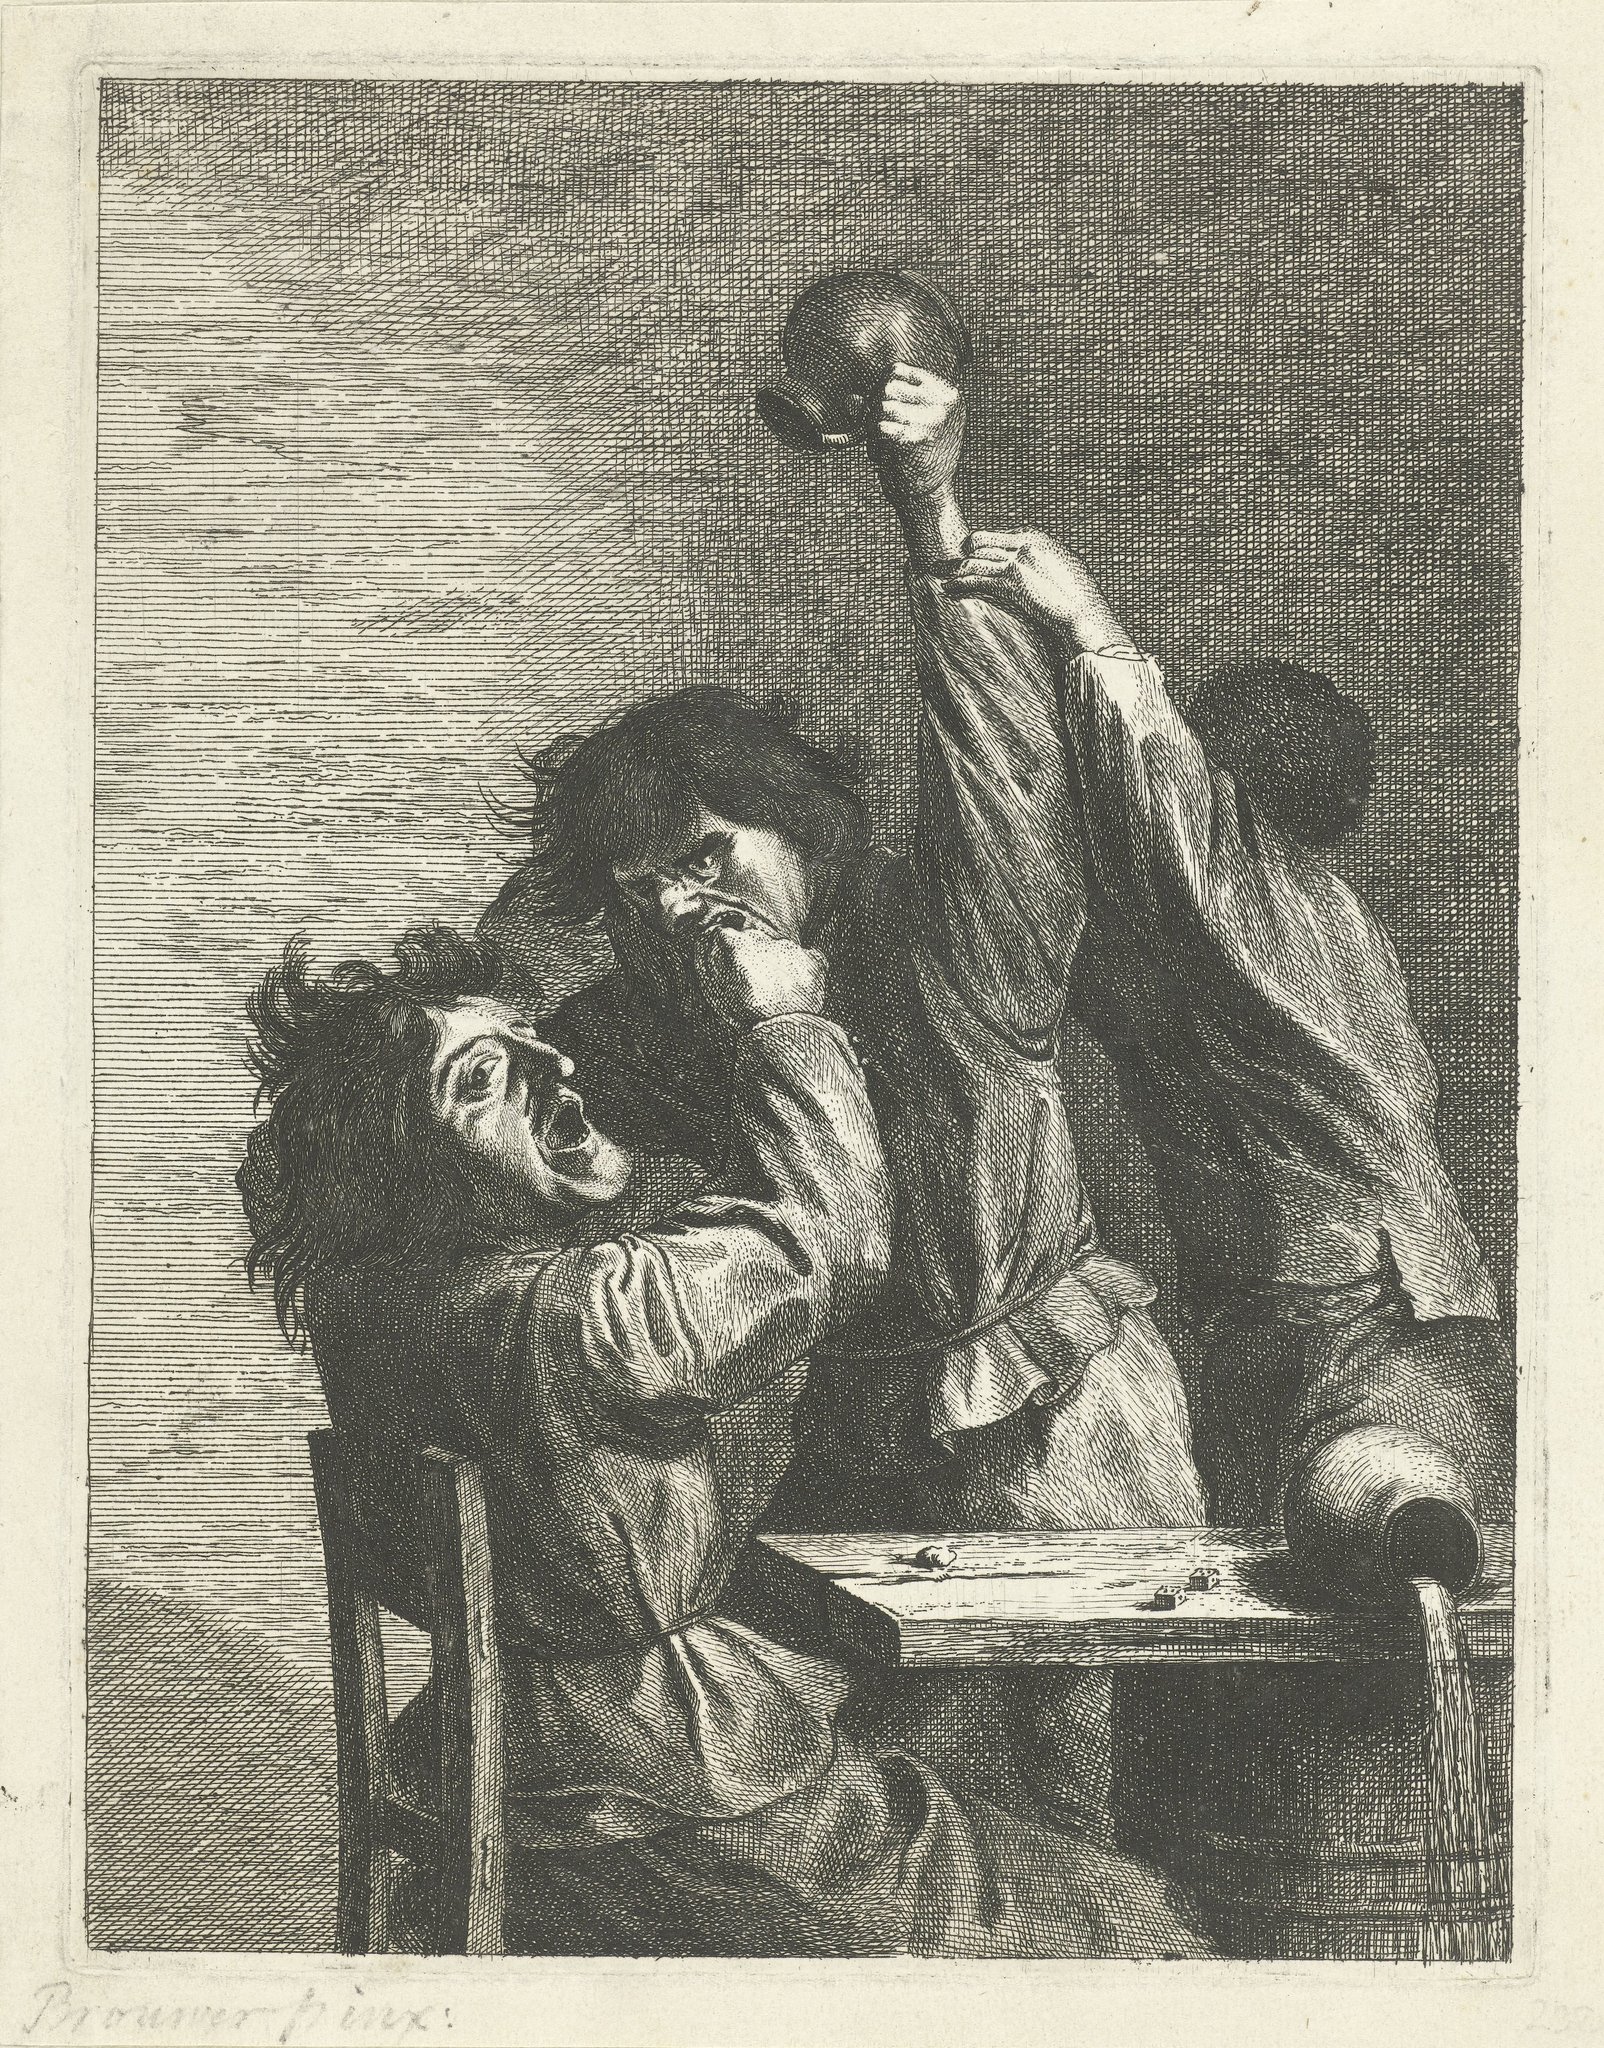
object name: print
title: Herberginterieur met vechtende boeren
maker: johannes gronsveld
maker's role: draughtsman, painter, print maker, publisher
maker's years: 1658-1728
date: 1679-1728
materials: paper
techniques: engraving, etching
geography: amsterdam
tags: drunken brawl (usually peasants fighting in an inn)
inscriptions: collector's mark: Lugt 240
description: Herberginterieur met drie vechtende boeren van wie een, zittend aan een tafel, in zijn hand gebeten wordt. De bijtende boer heeft een kruik in zijn handen. De derde boer probeert hem tegen te houden. Rechts op de tafel een omgevallen kruik.